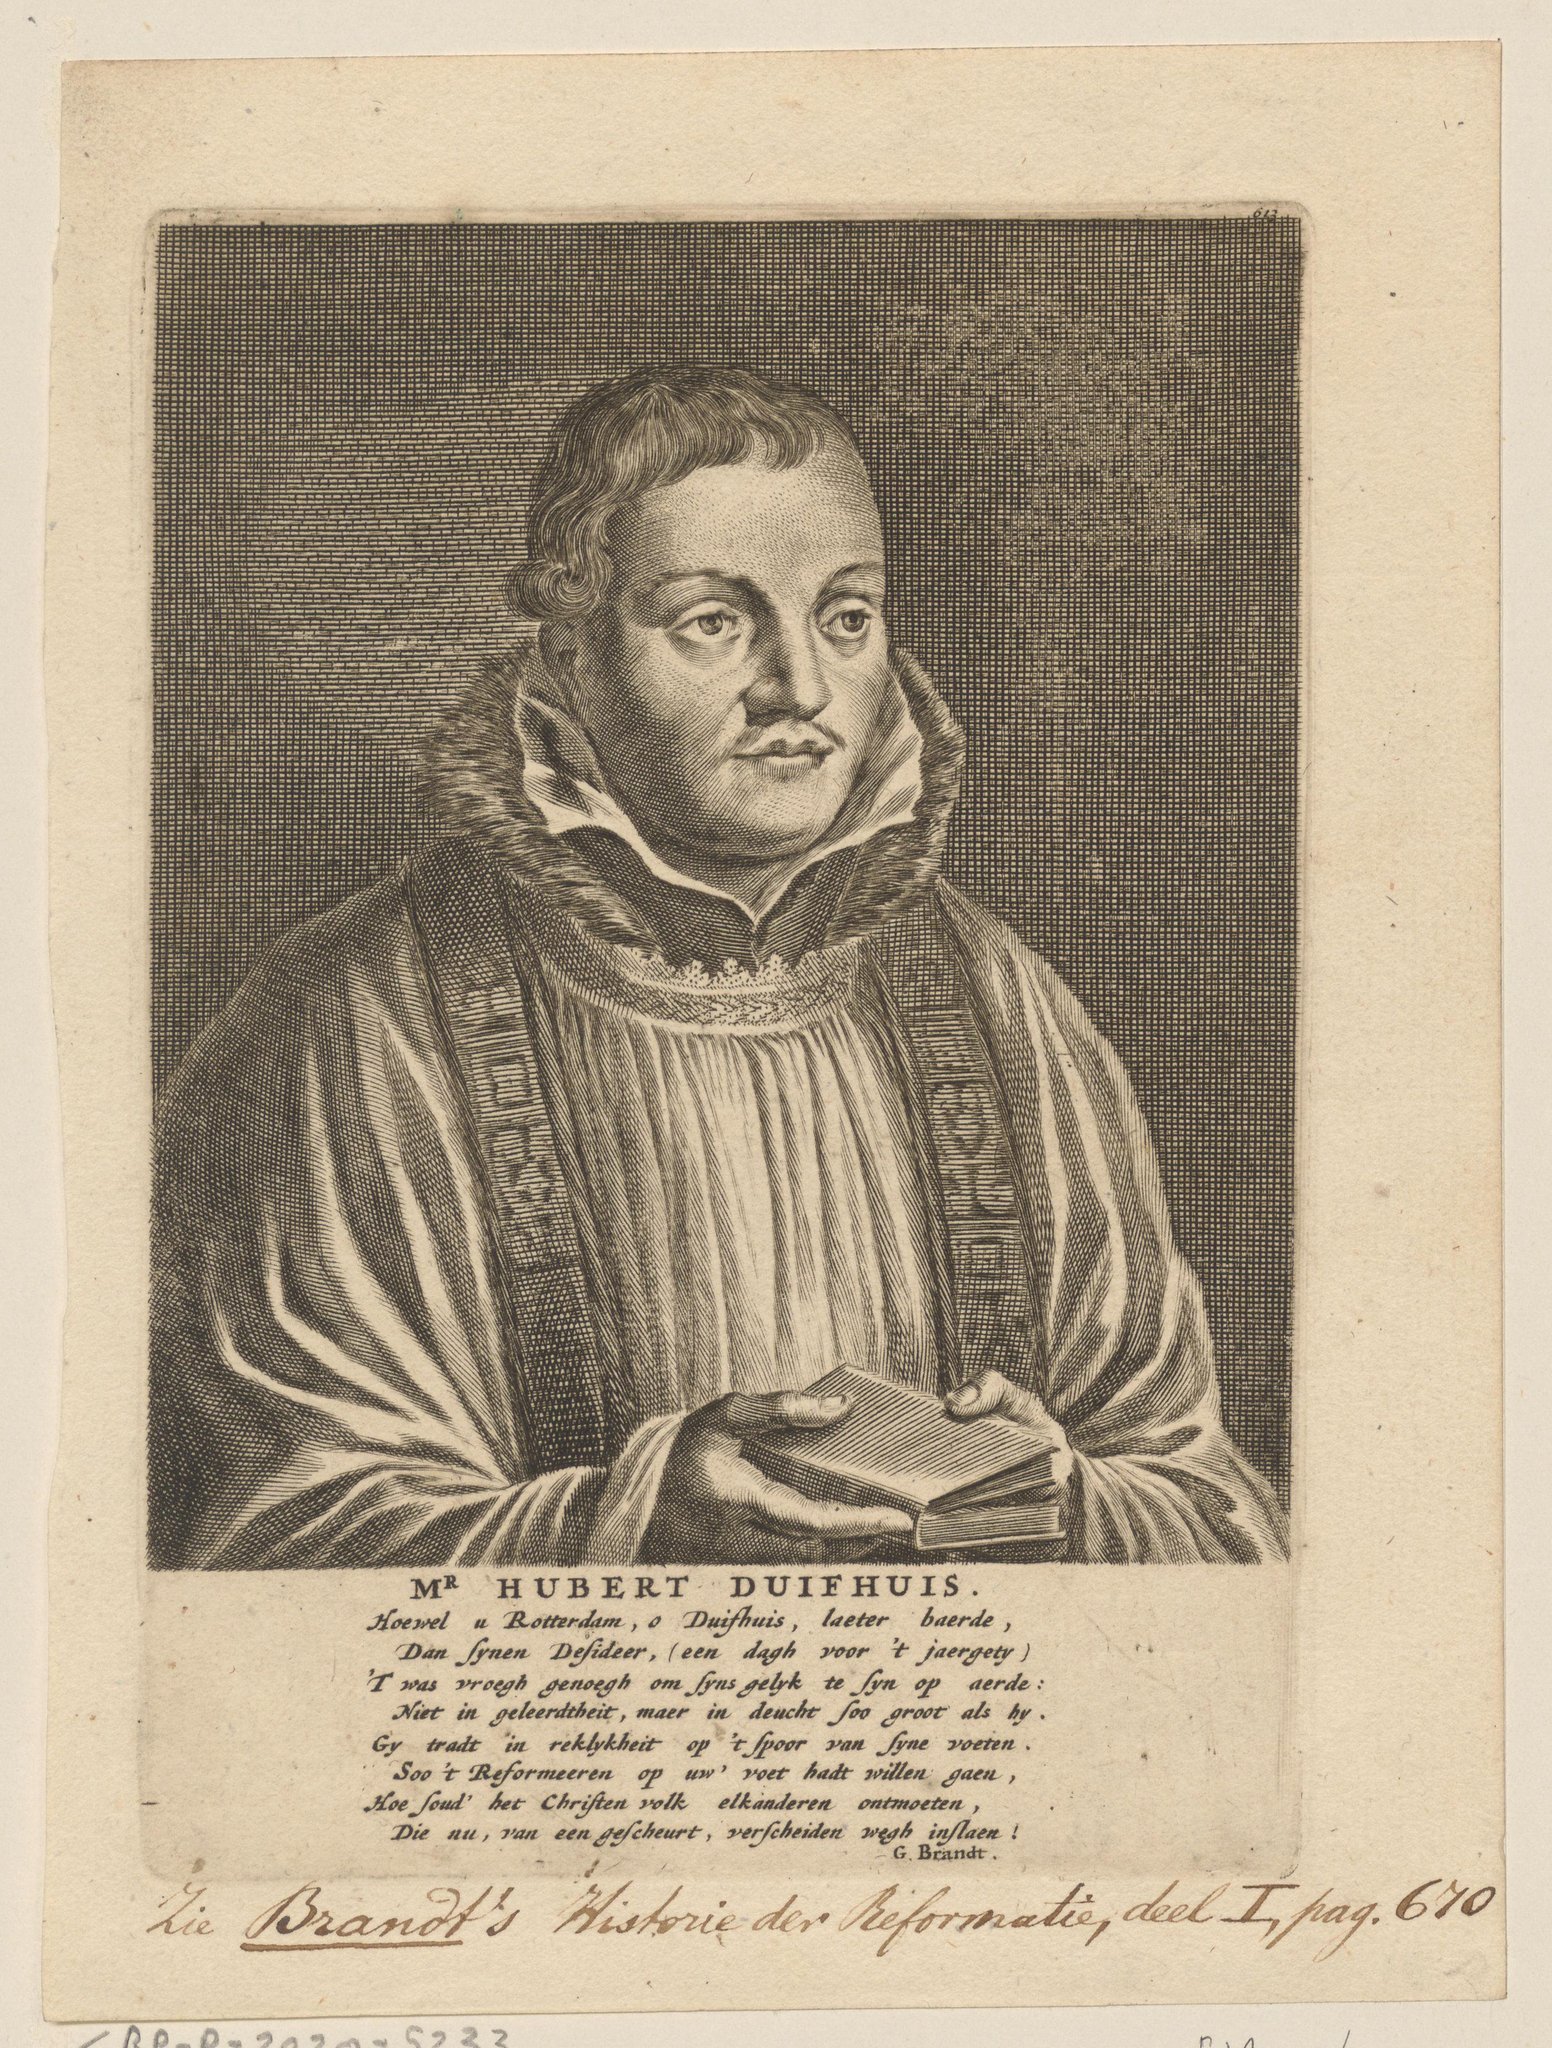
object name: print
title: Portret van Huibert Duifhuis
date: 1671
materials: paper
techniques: engraving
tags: reformation (roman catholic church vs. protestantism), historical persons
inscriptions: collector's mark: Lugt 2228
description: Prent waarschijnlijk uit: G. Brandts Historie der Reformatie (...). Amsterdam: Jan Rieuwertsz., Hendrik en Dirk Boom, 1671, dl. 1.